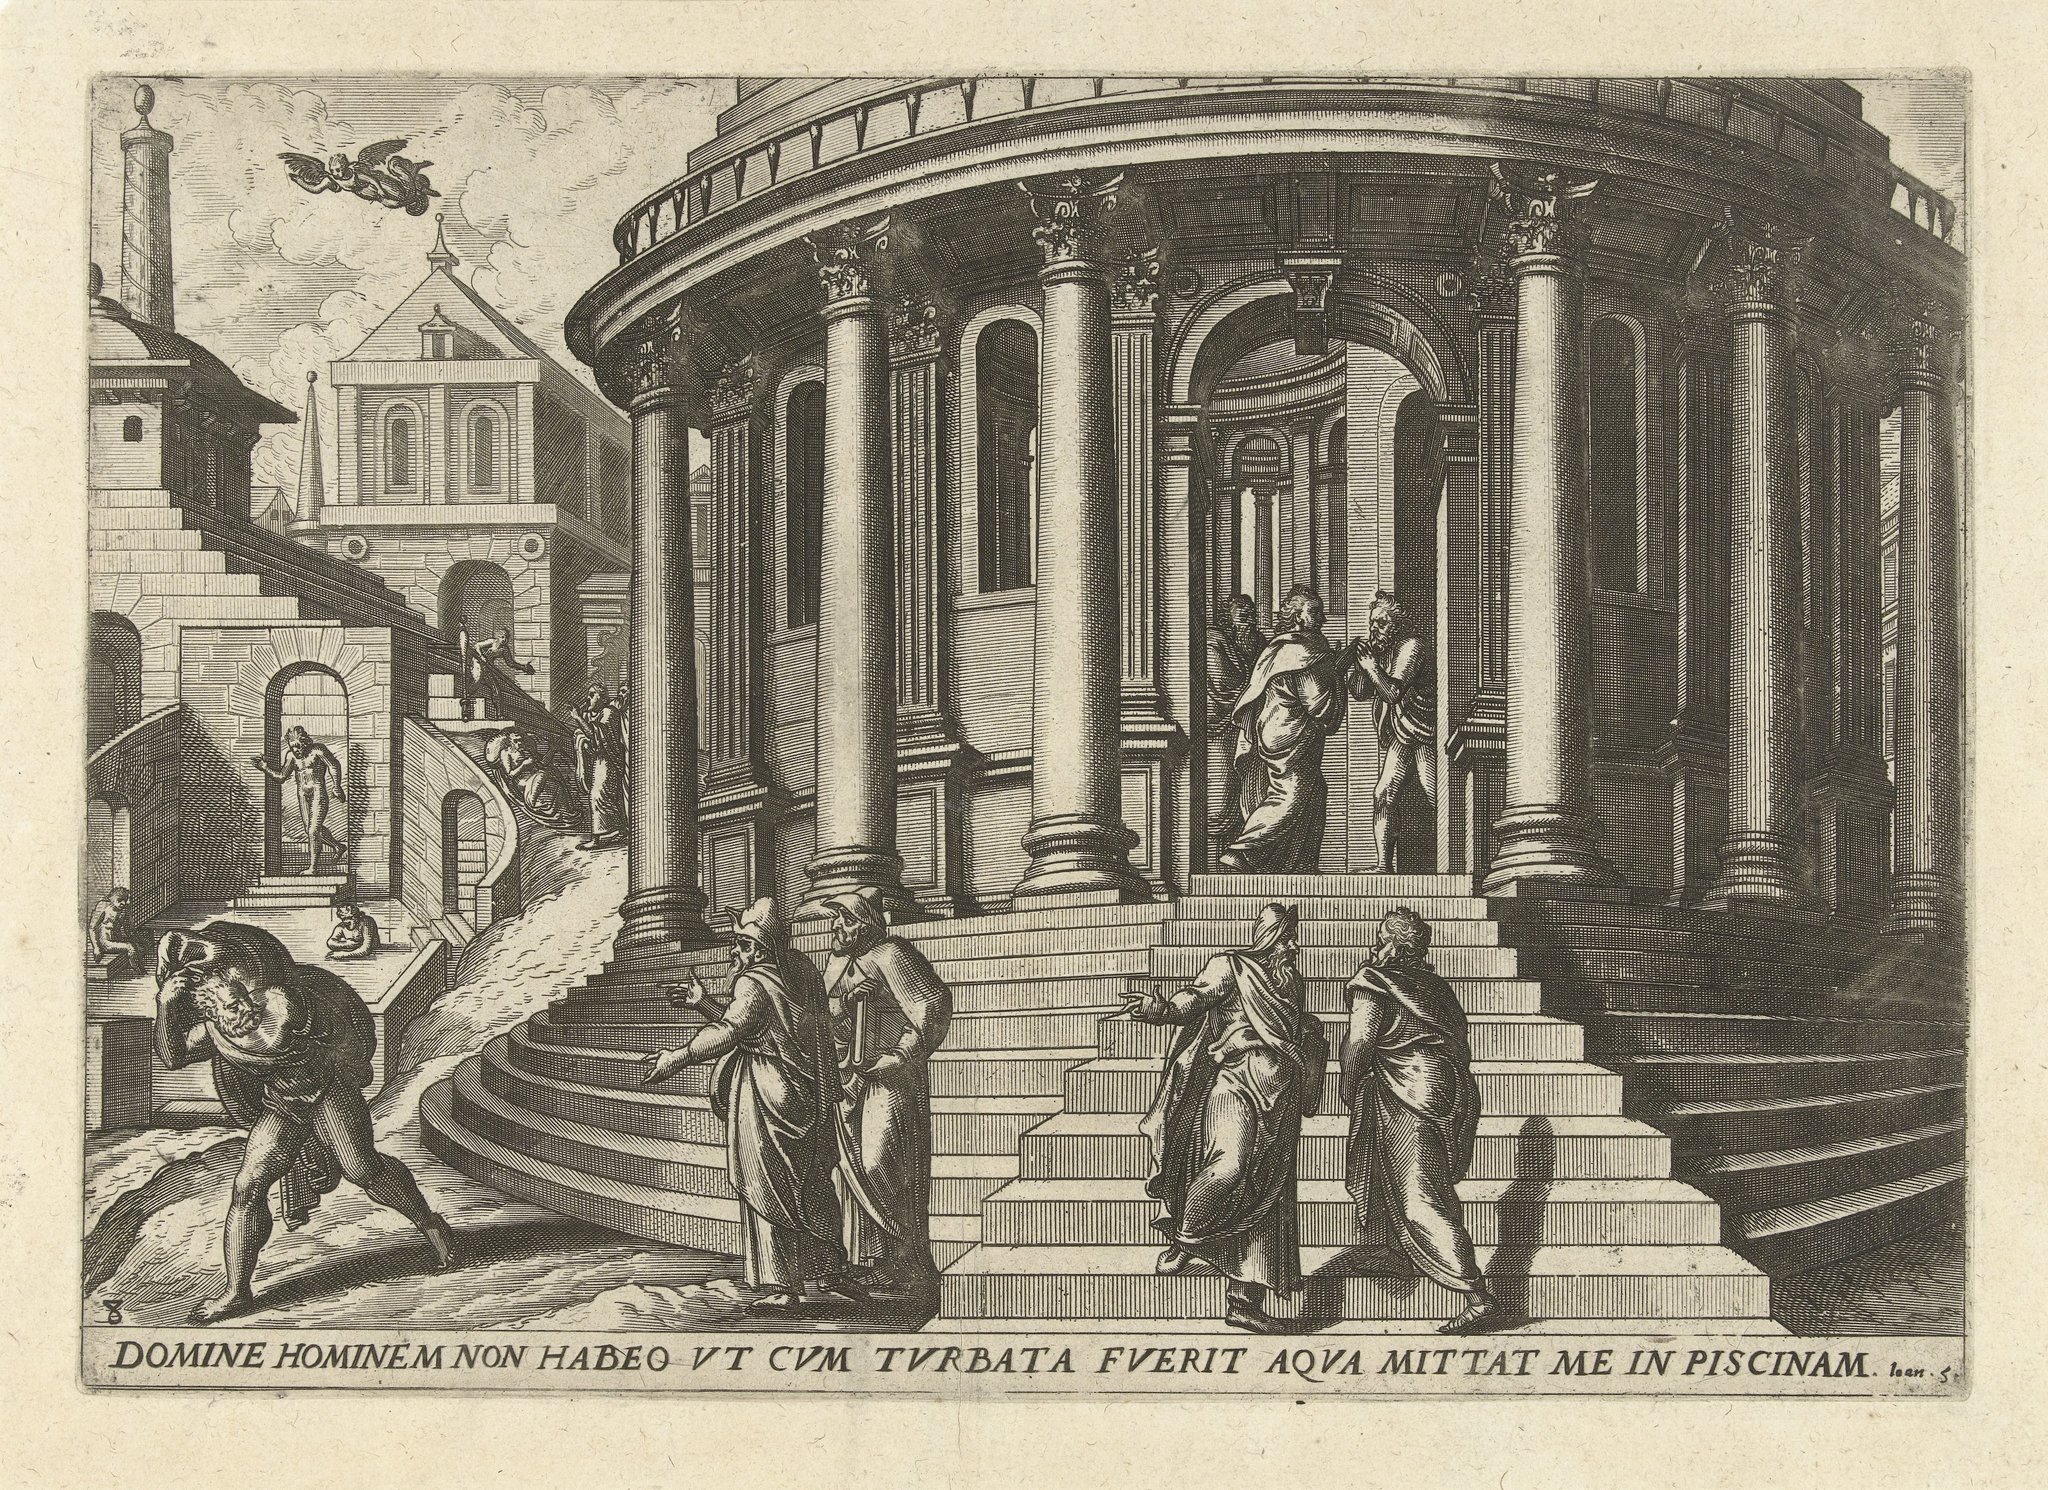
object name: print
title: Memorabilivm Novi Testamenti in templo gestorvm icones tredecim elegantissimi ac ornatissimi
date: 1572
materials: paper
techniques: engraving, etching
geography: antwerp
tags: christ says to a paralytic man: 'rise, take up your pallet (bed)', the paralytic man is cured and walks away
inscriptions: collector's mark: Lugt 2228, collector's mark: Lugt 2760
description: Christus loopt op sabbat langs het bad van Betzata waar veel zieken liggen. Hij geneest een zieke man die vervolgens weer kan lopen en met zijn slaapmat wegloopt. De omstanders kijken hem met verbazing na.